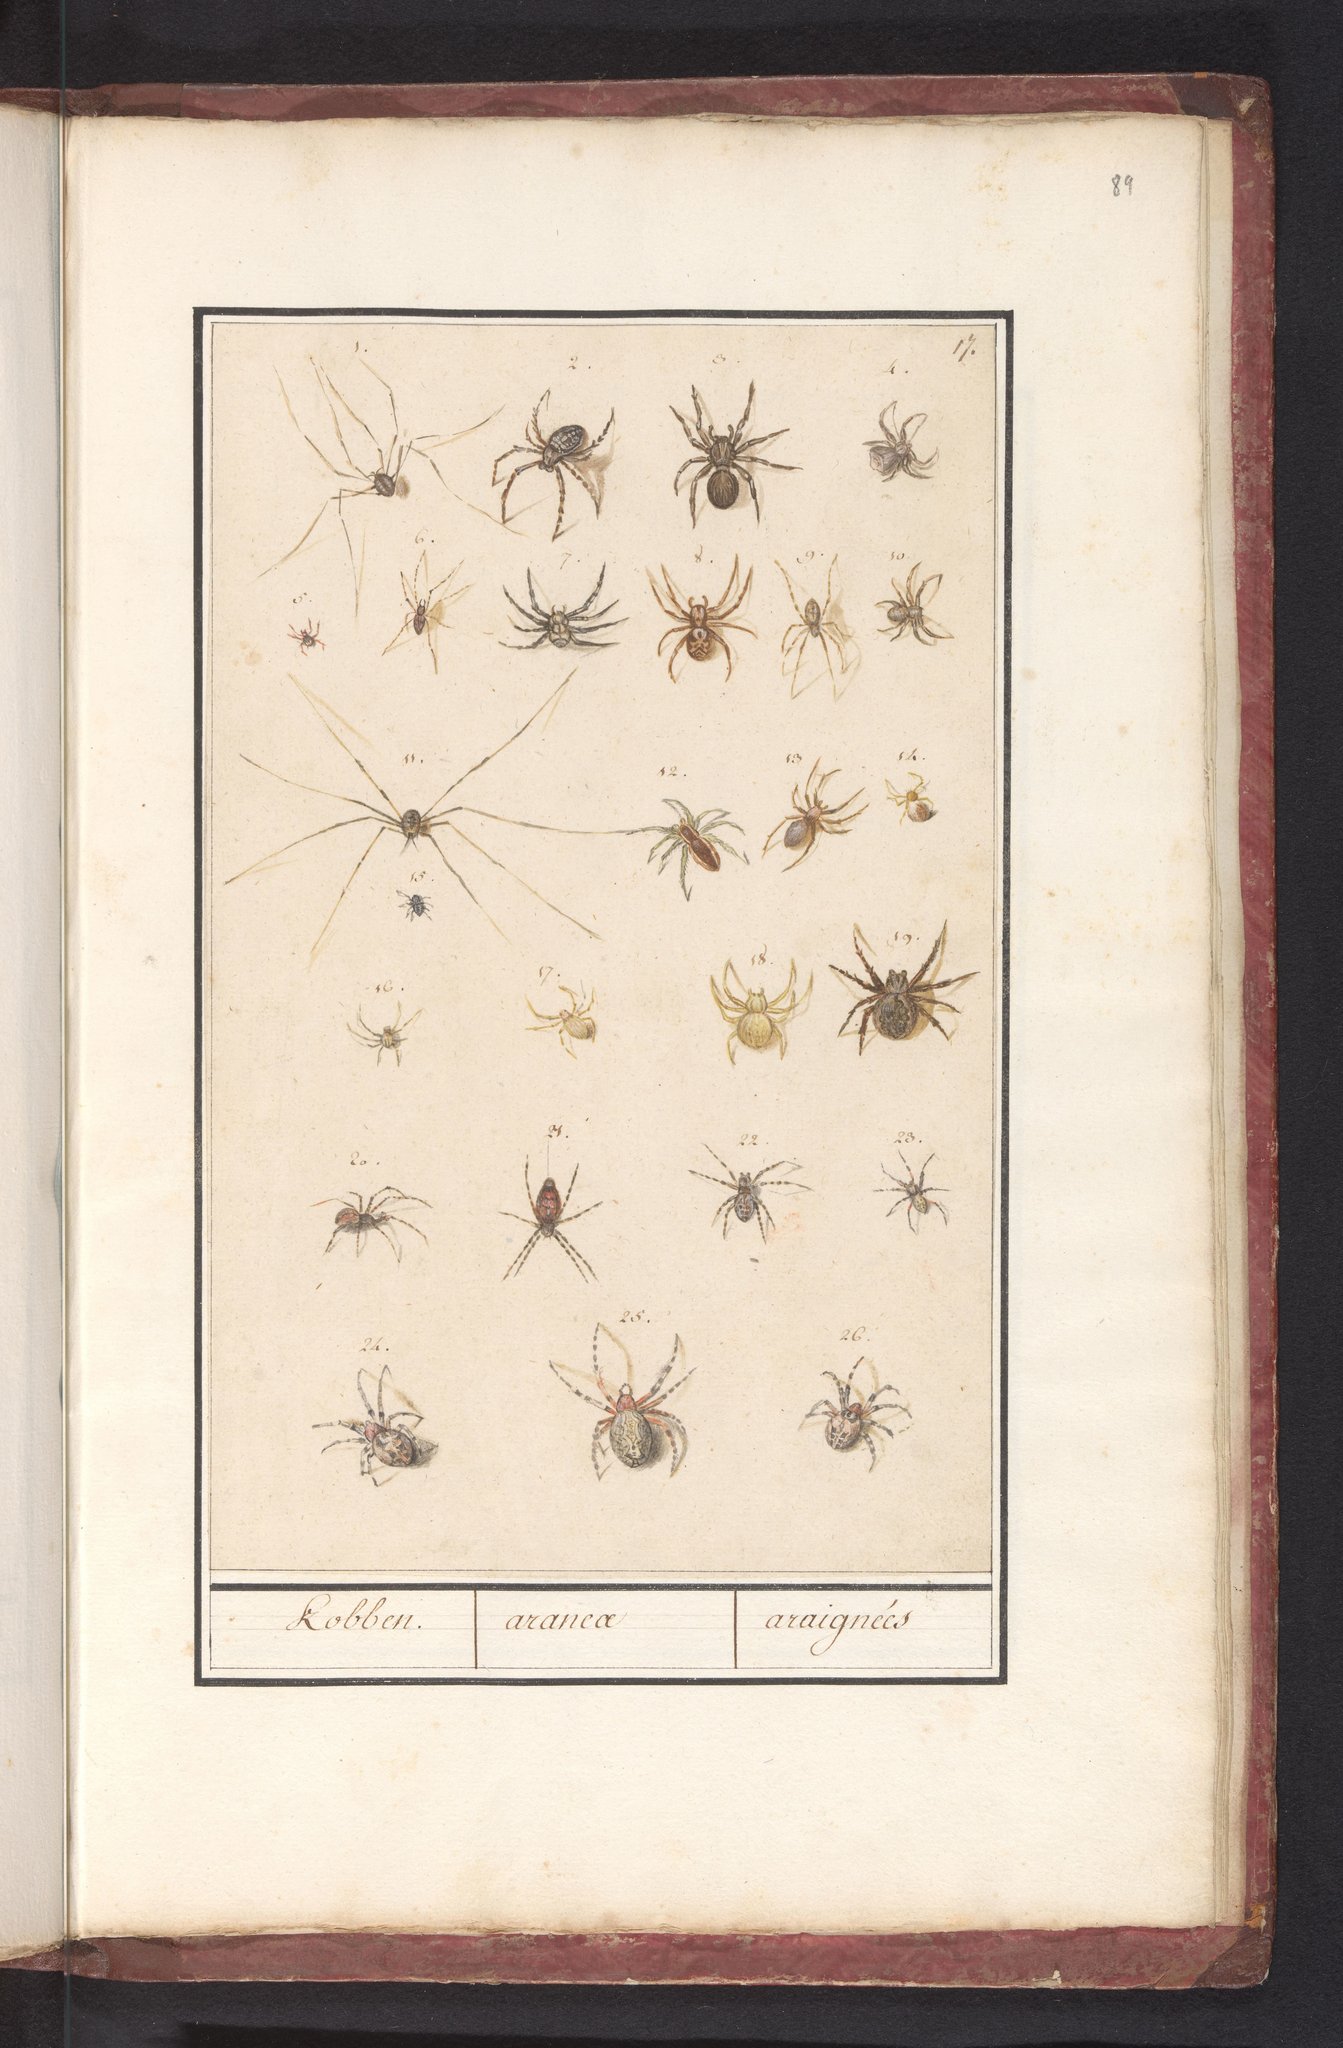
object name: drawing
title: Sheet with Spiders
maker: anselmus boëtius de boodt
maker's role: draughtsman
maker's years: 1550-1632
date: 1596-1610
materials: chalk, paint, ink, paper, pencil, watercolor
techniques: brush, pen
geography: prague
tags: spiders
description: This sheet features 26 different species of spiders. For most of these eight-legged creatures, De Boodt also rendered their shadows, making it seem as if they are crawling across the paper. The term ‘kobben’ for spiders – inscribed at the lower left within the framing line –occurs in West Flanders, where the albums were when the mayor of Bruges, Joseph van Huerne, owned them.